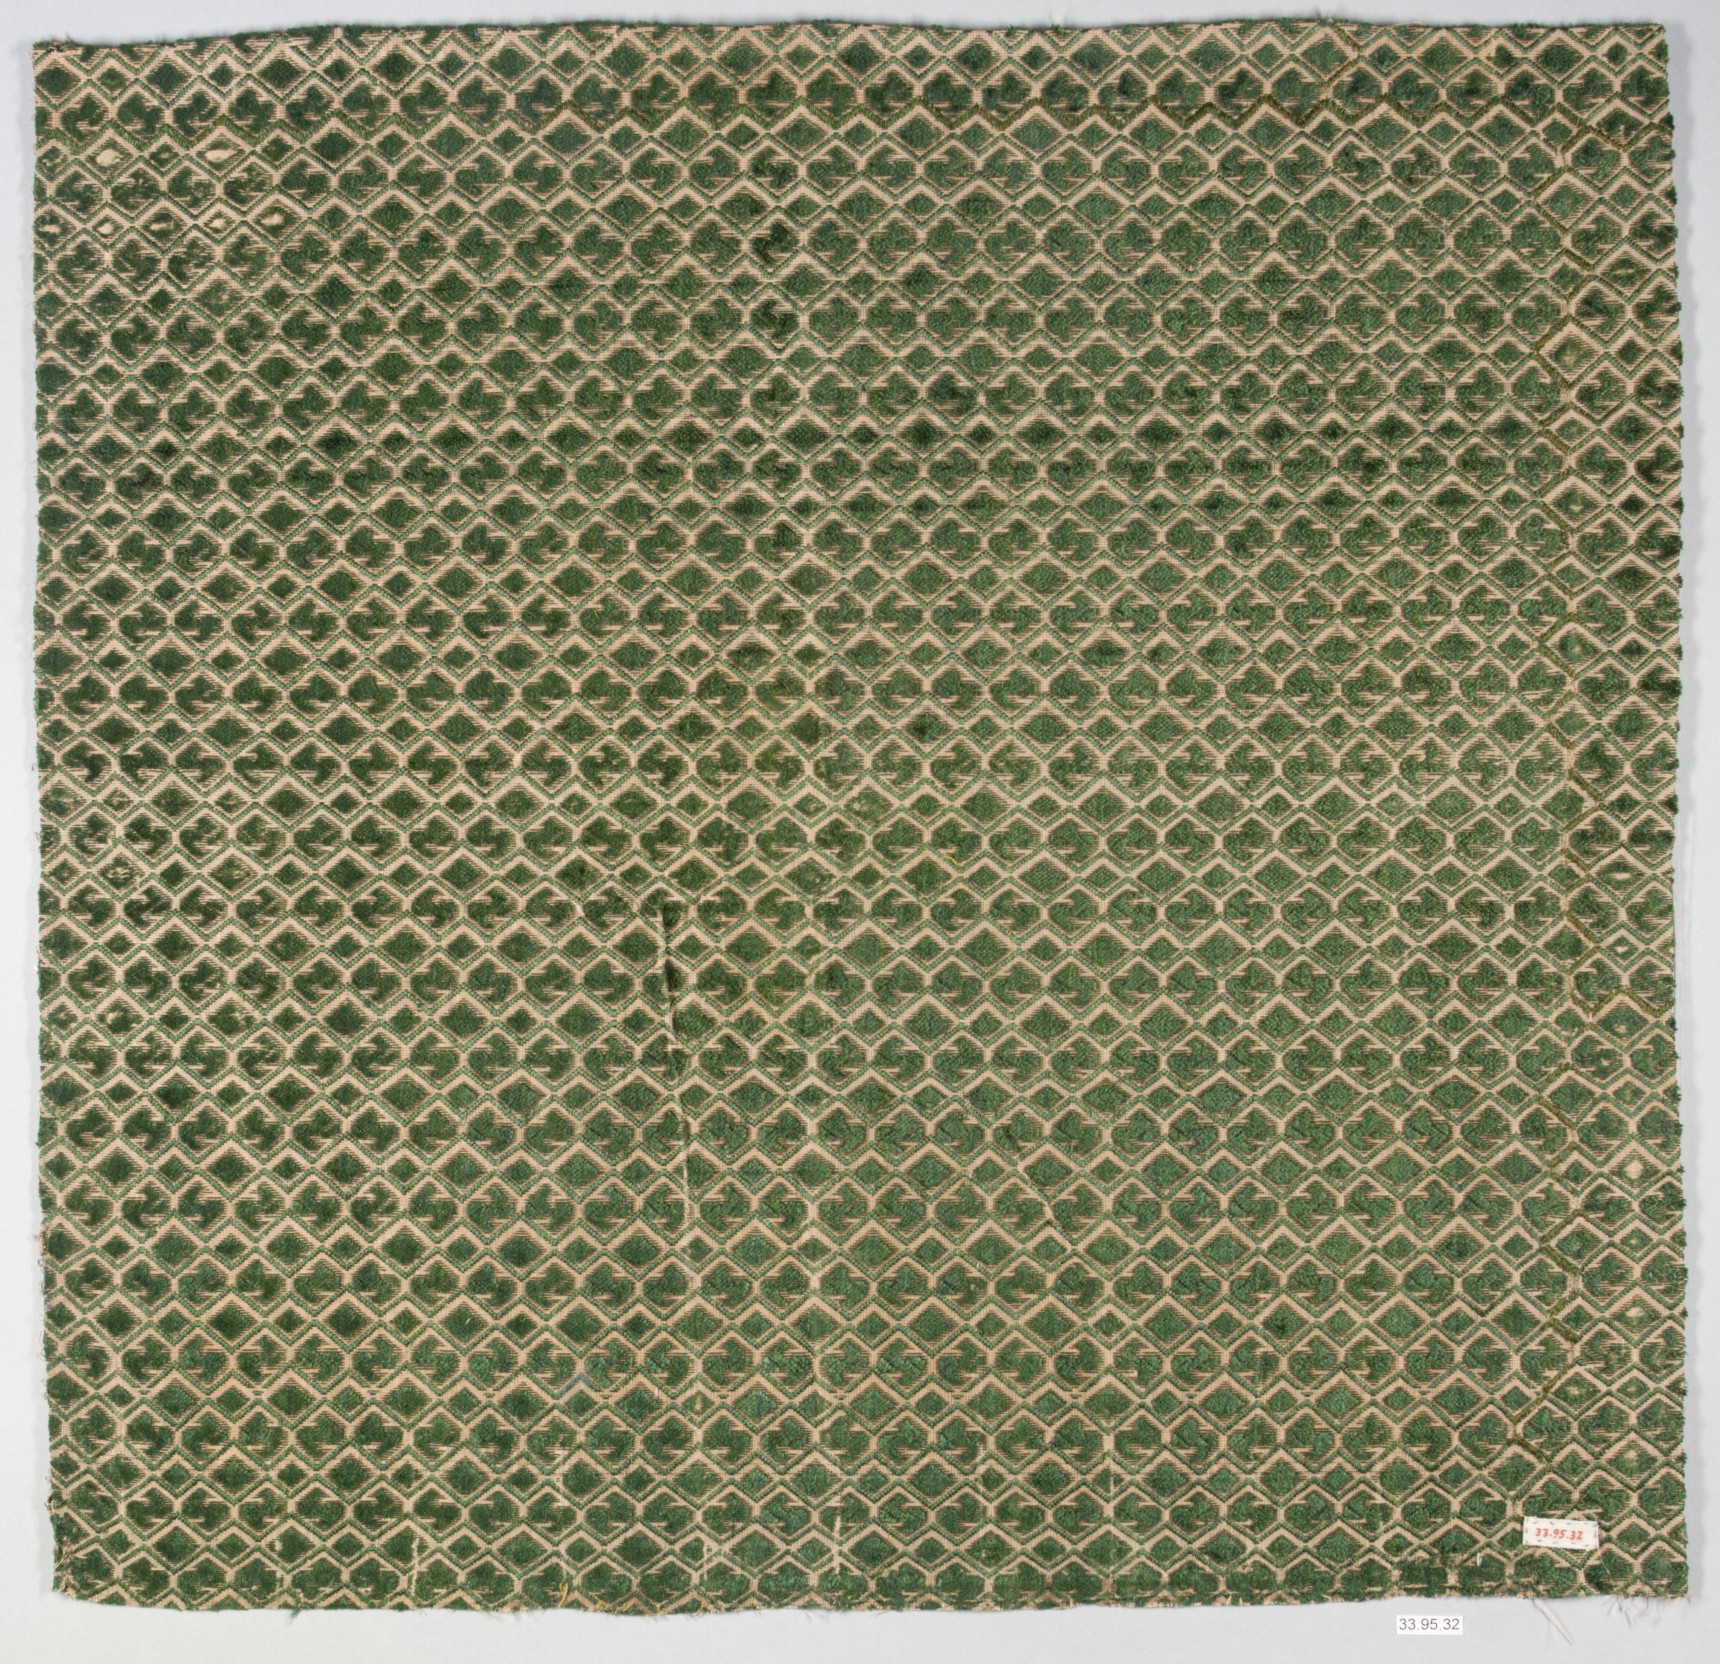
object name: piece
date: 1501-1700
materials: silk